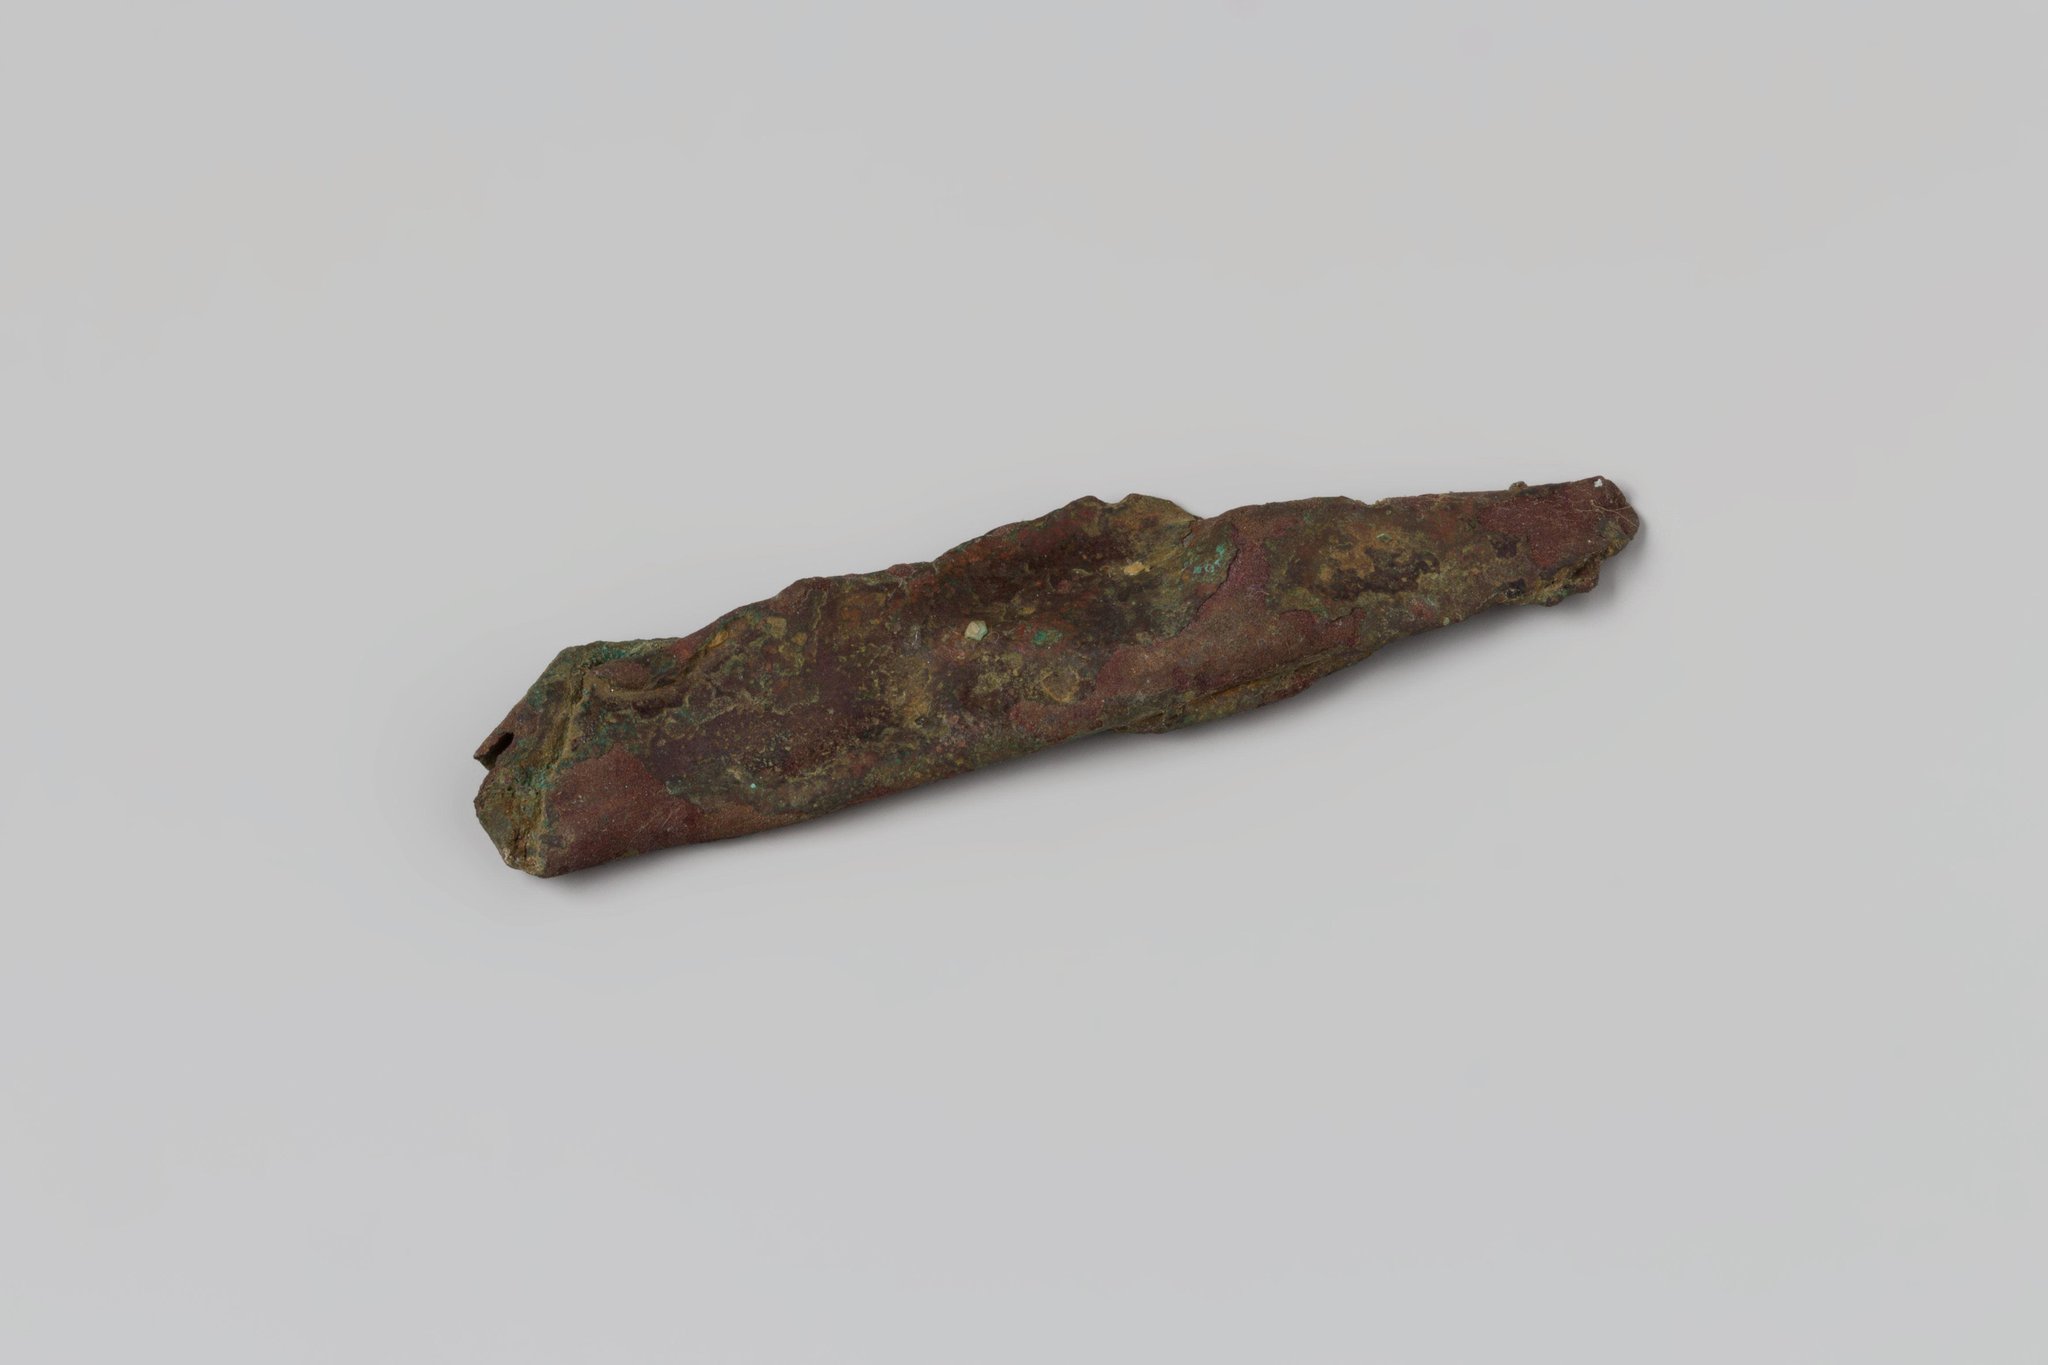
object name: scheepswrakvondst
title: Fragment van koper uit het wrak van de Oost-Indiëvaarder Hollandia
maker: Anonymous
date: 1700-1743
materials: copper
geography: netherlands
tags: verenigde oostindische compagnie, hollandia (schip), annet